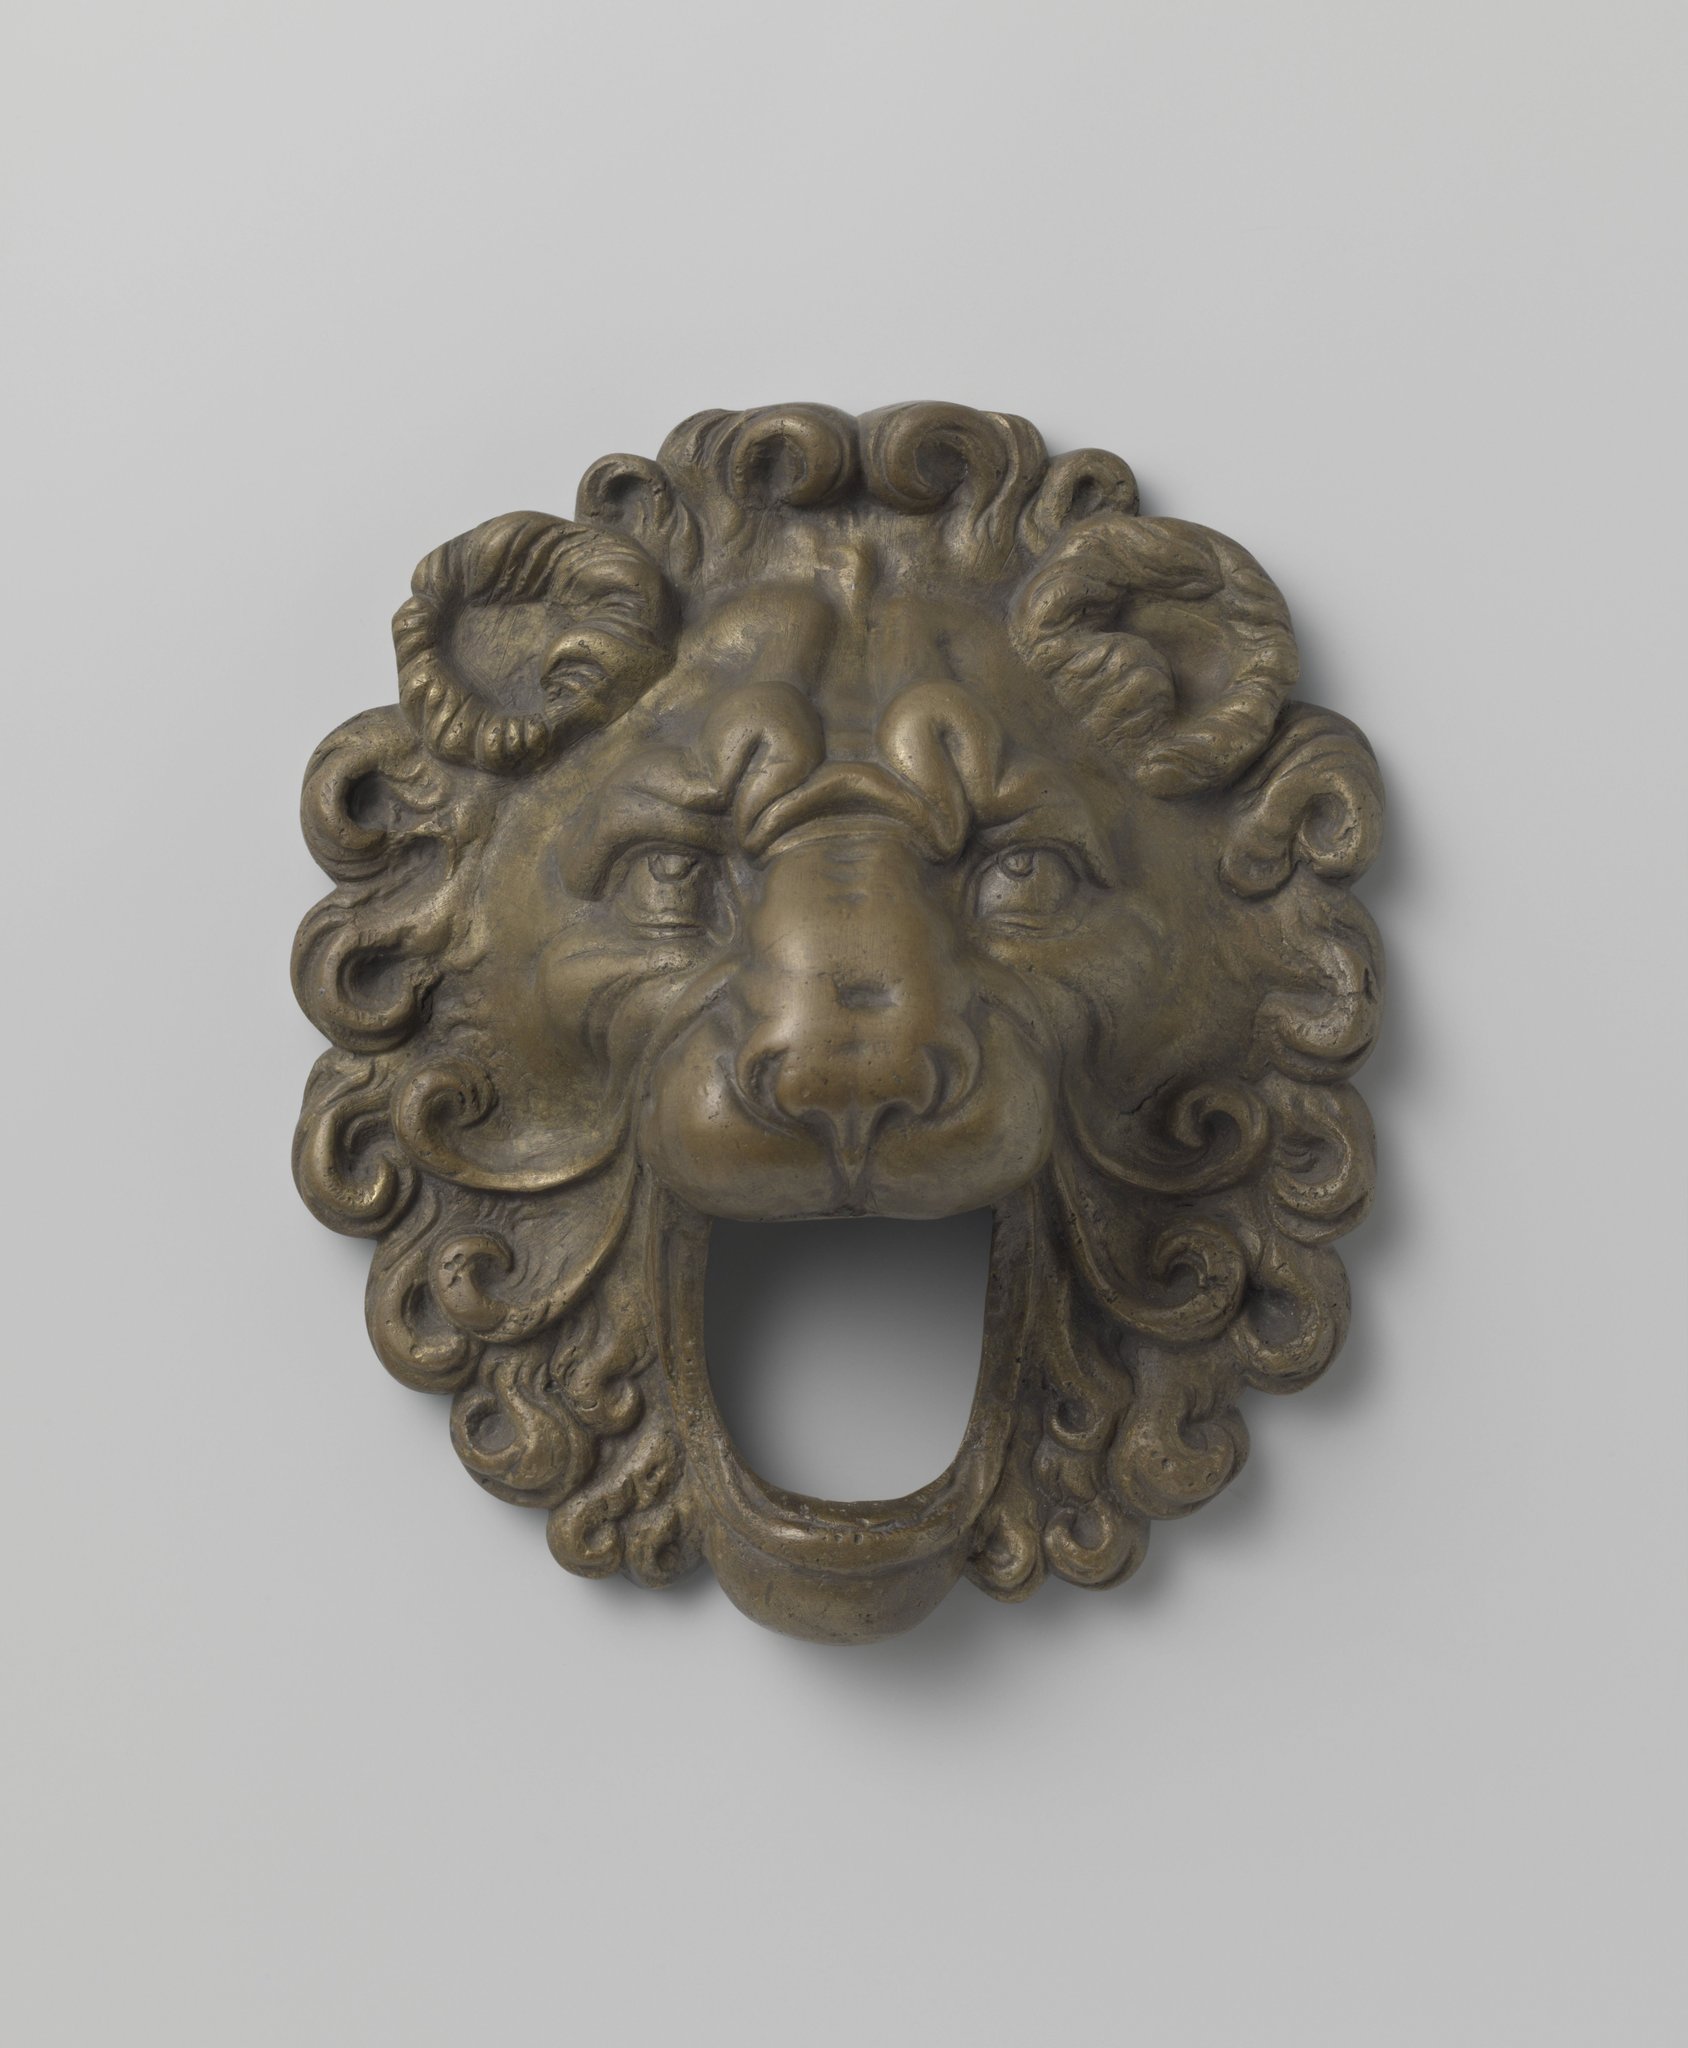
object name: waterpomp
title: Versiering van een buiseind van een waterpomp, in de vorm van een leeuwenkop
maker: Anonymous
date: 1650-1700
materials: brass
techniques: casting, metalworking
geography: southern netherlands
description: Het gegoten en bijgeciseleerde voorwerp heeft de vorm van een leeuwenkop met opengesperde muil.